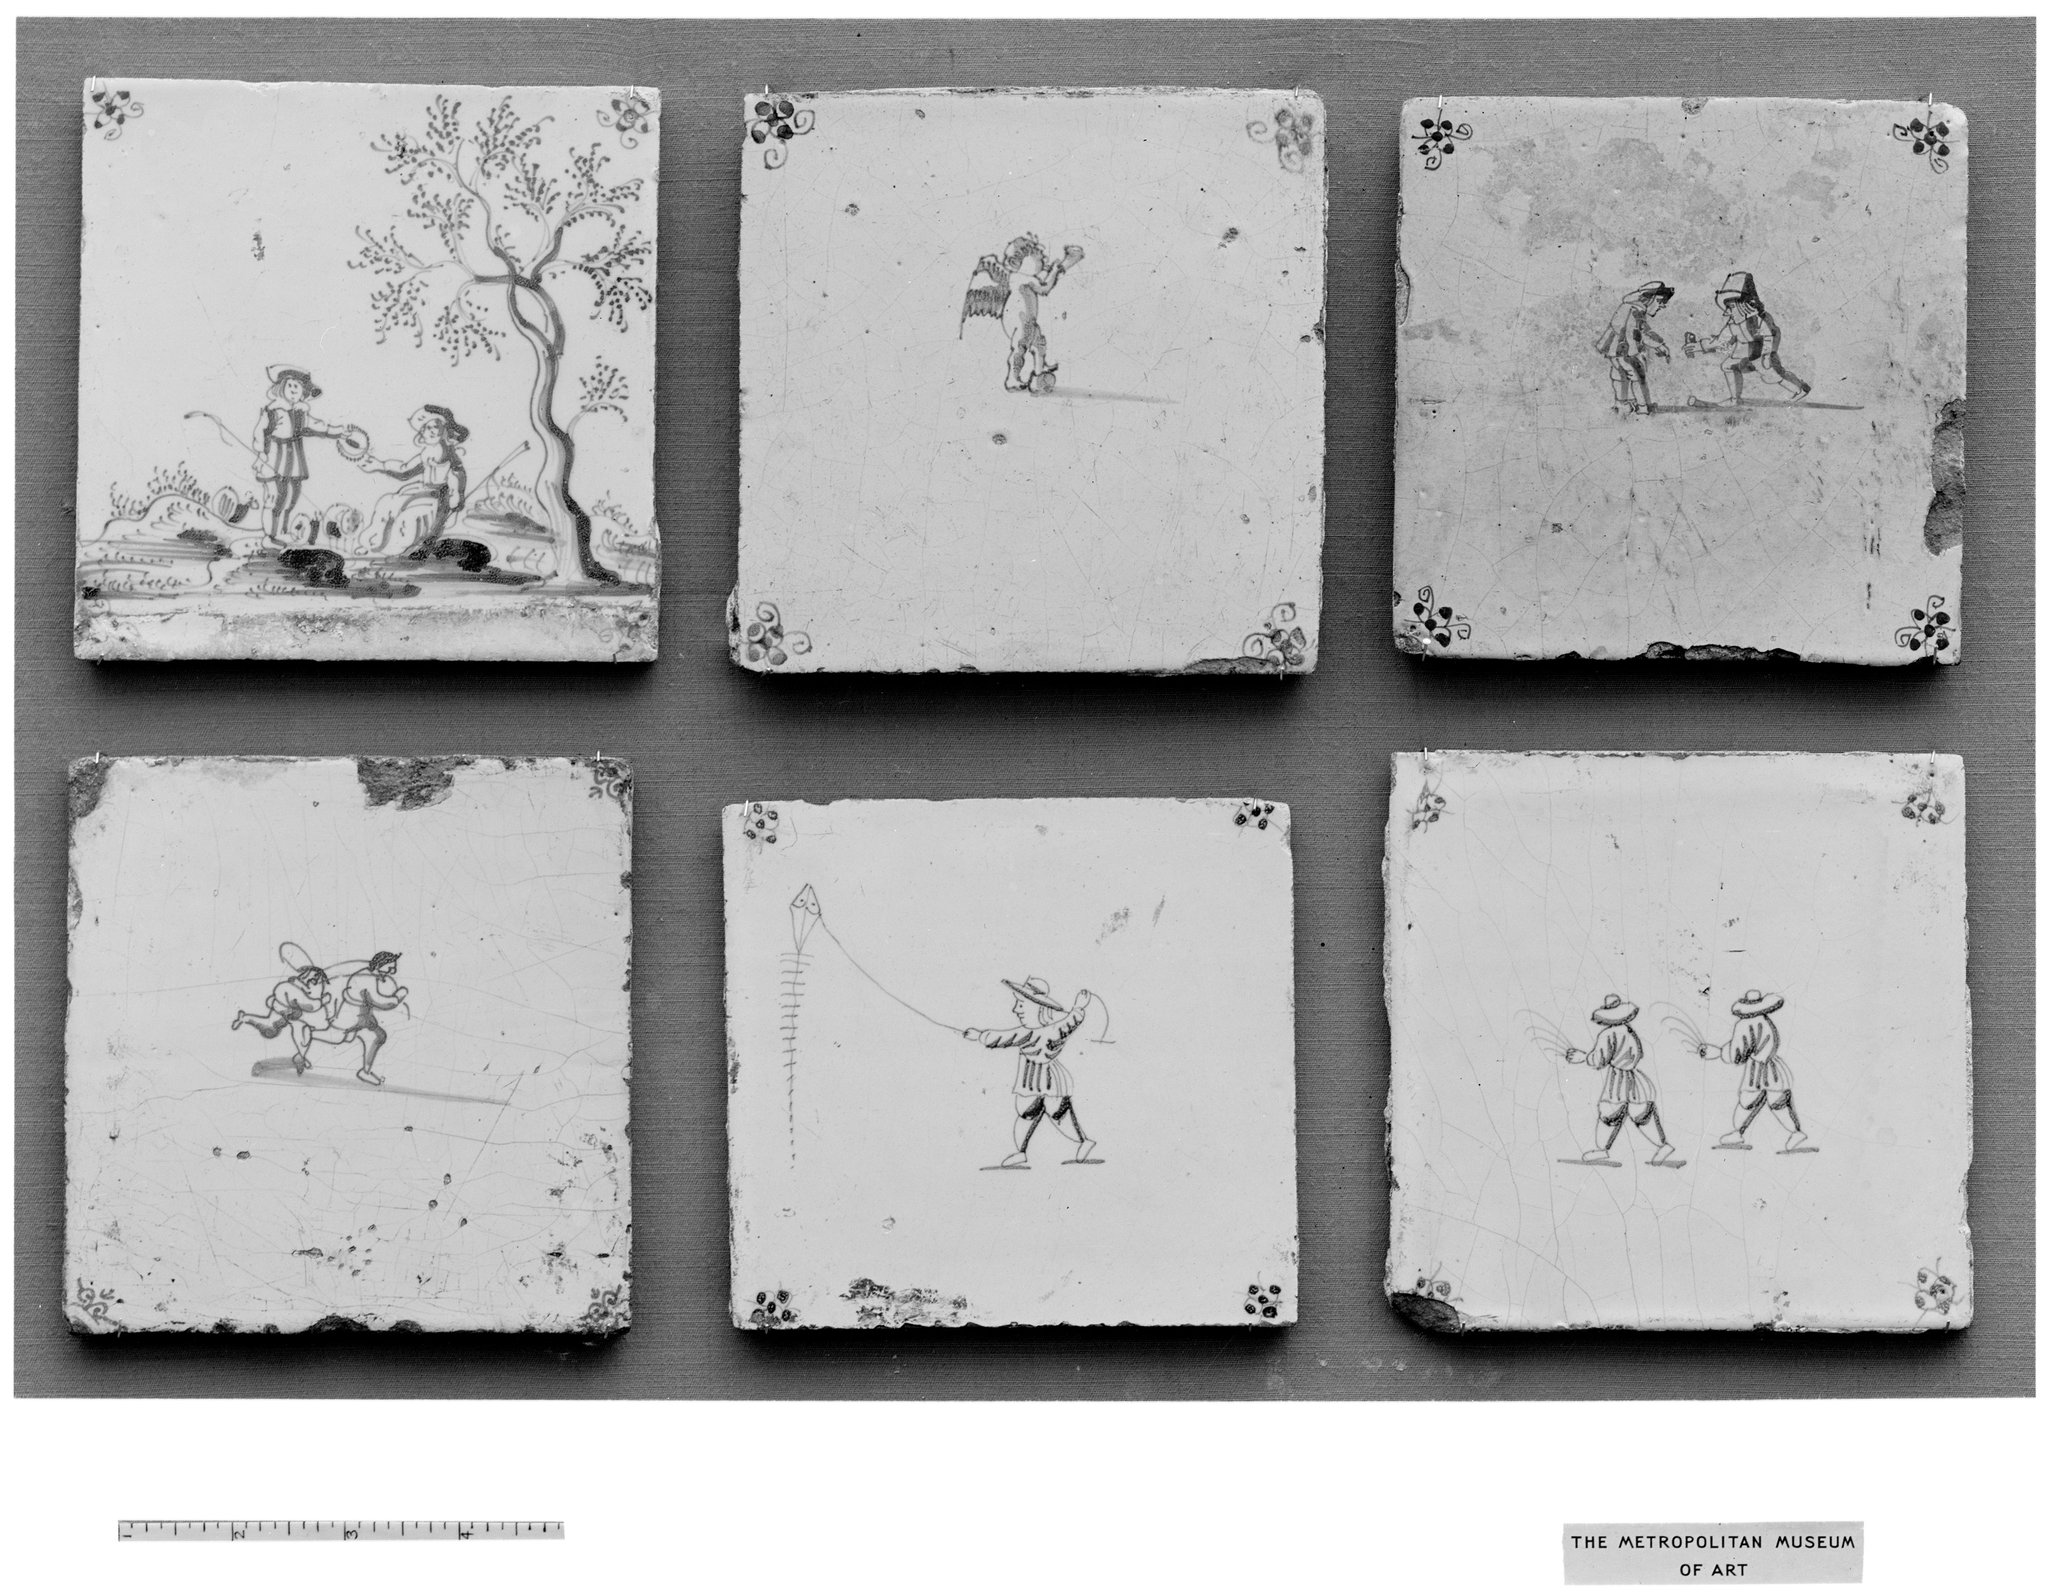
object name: tile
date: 1701-1800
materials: earthenware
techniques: glazing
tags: men,trees